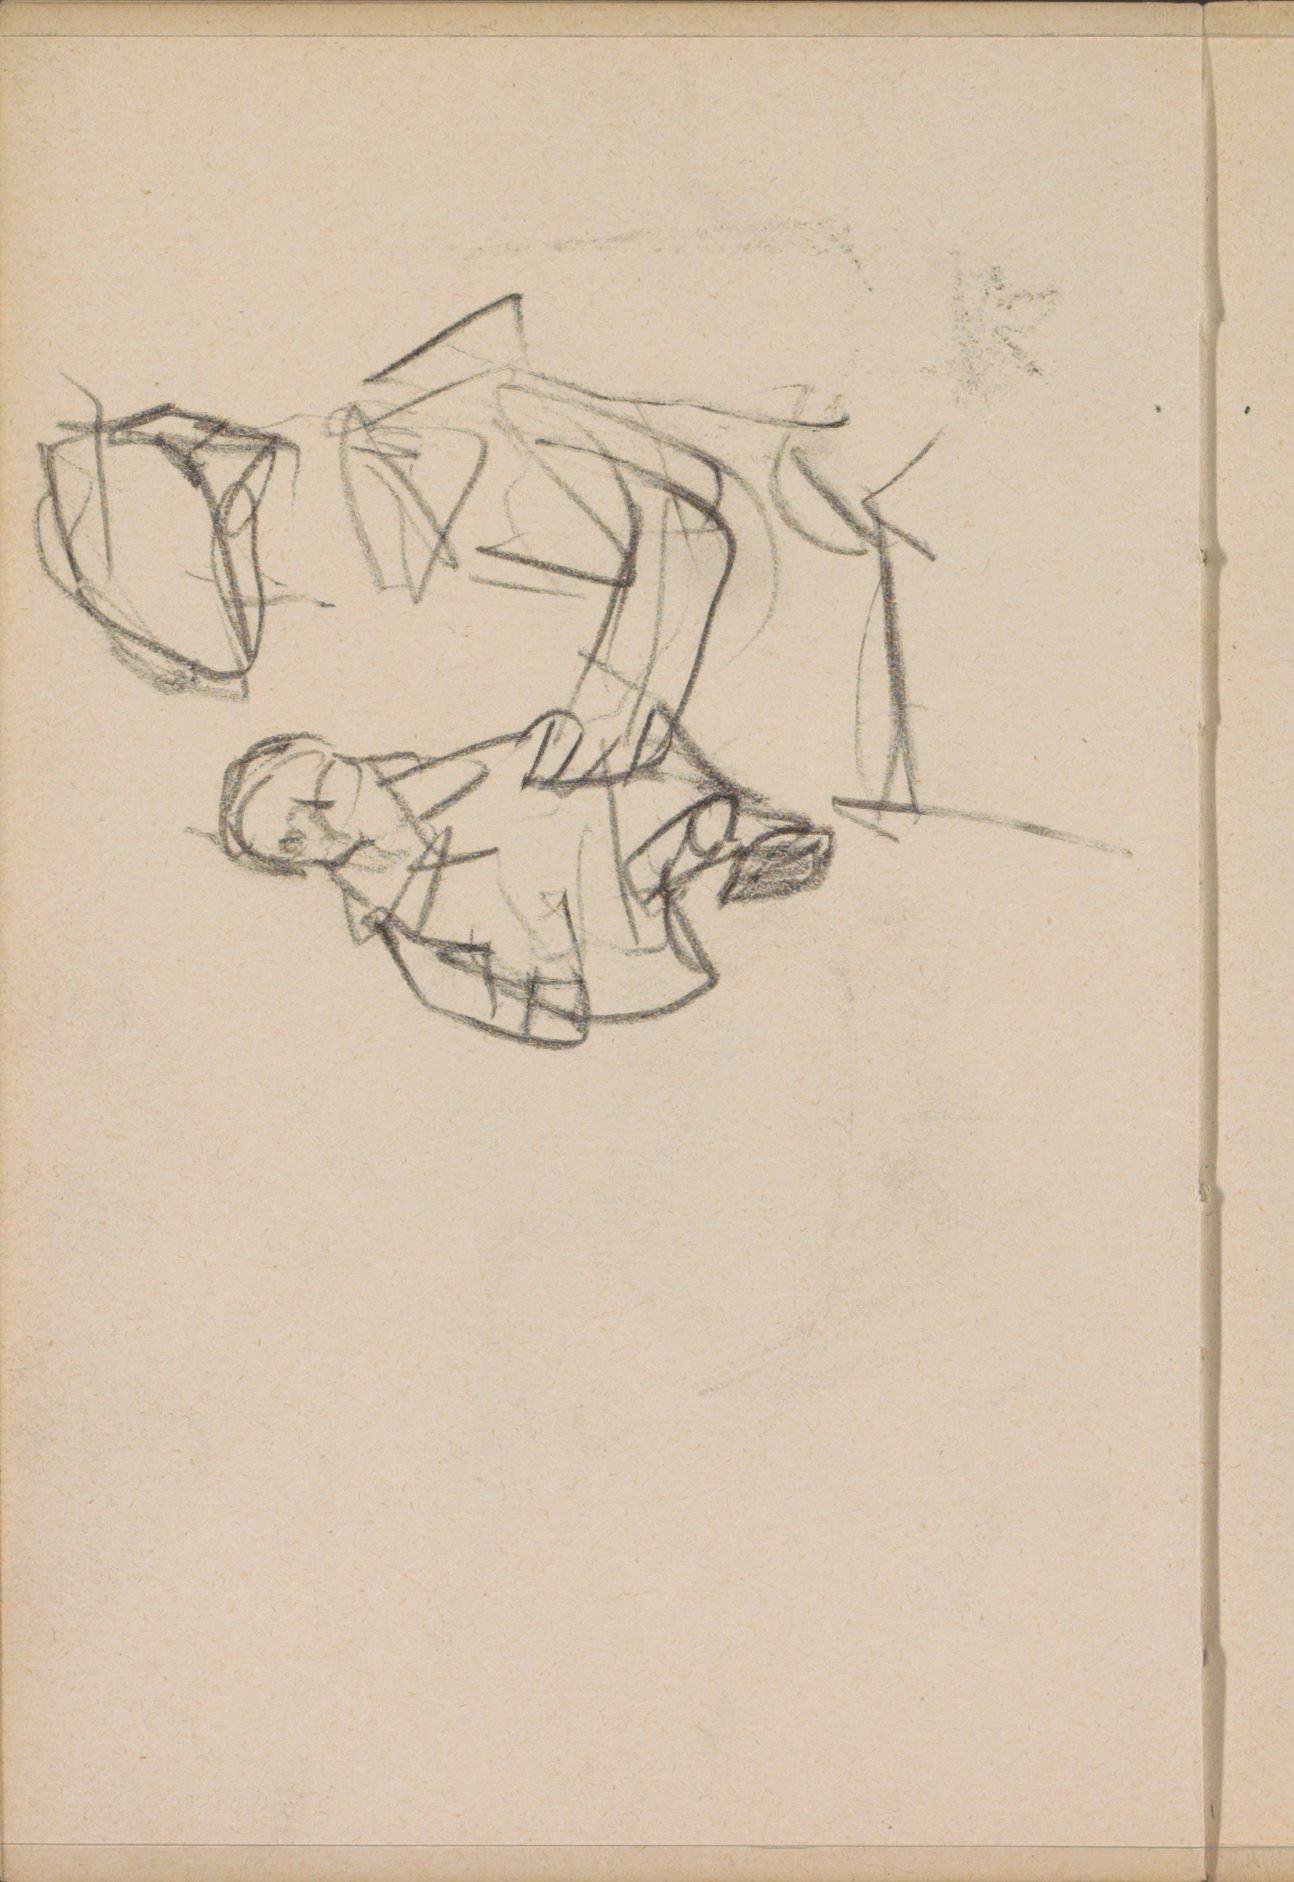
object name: sketchbook leaf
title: Vrouw met kind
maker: george hendrik breitner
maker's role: draughtsman, painter, print maker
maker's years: 1857-1923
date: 1886-1903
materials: chalk, paper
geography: amsterdam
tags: mother and child(ren), woman and child(ren) (family group)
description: Pagina 19 uit een schetsboek met 46 bladen.